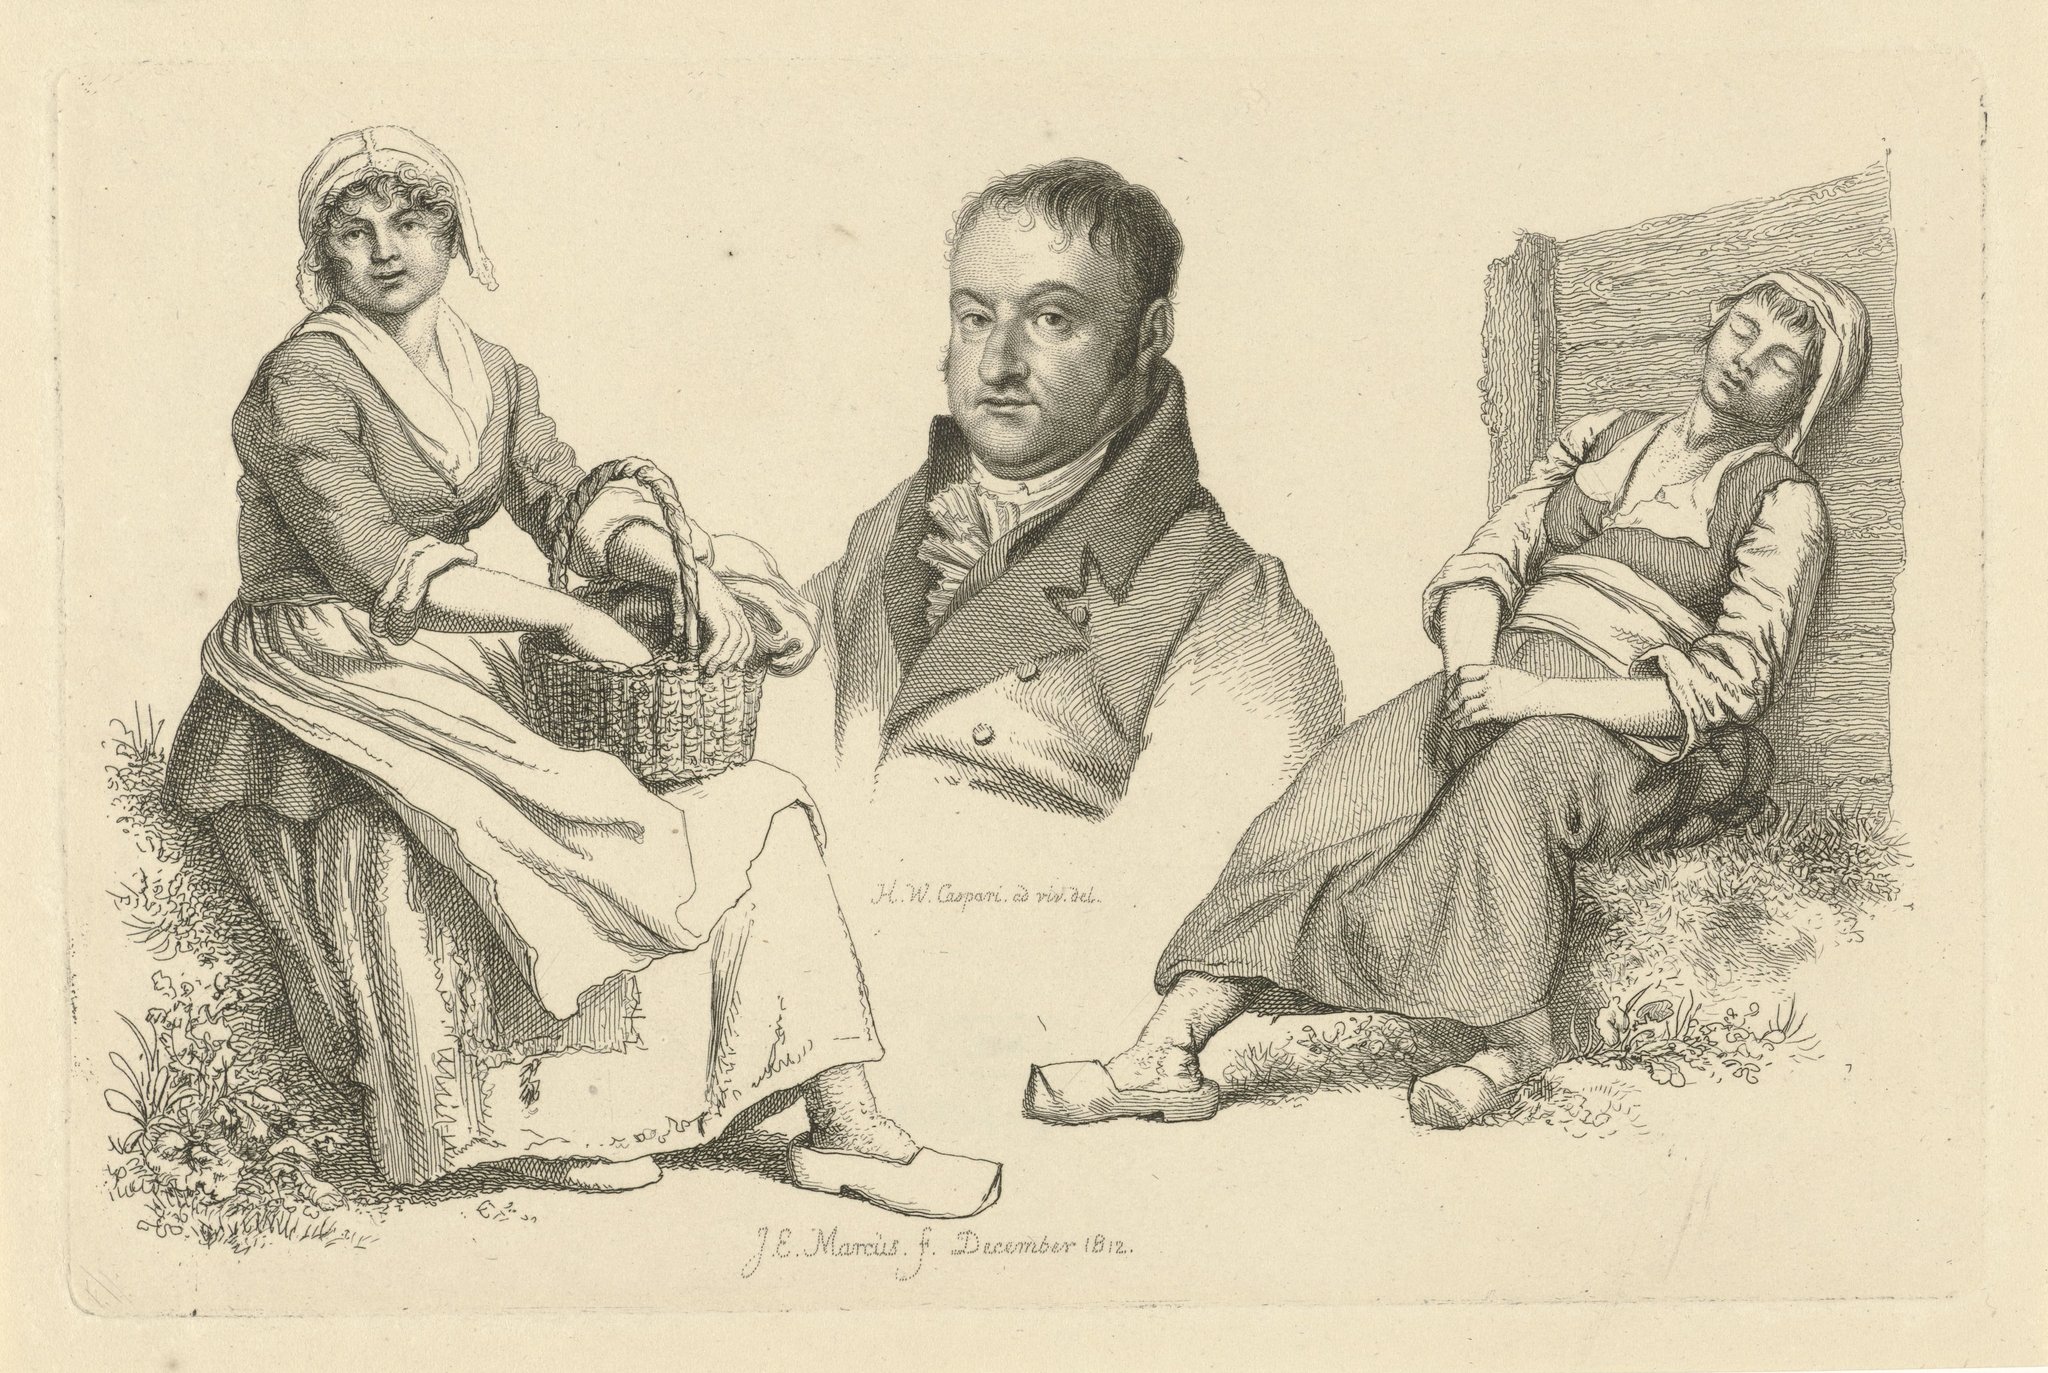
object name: print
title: Portret van Daniel Vrijdag tussen twee boerinnen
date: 1812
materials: paper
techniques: etching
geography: amsterdam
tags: amsterdam, print maker, draughtsman, daniël vrijdag, sitting figure - aa - female human figure, sleeping; unconsciousness - bb - out of doors, wooden shoes, clogs, farmers - aa - female farmer, farmer's wife, container made of plant material other than wood: basket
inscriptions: collector's mark: Lugt 2228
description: Serie voor het eerst uitgegeven door Jacob Ernst Marcus onder de titel Studiebeelden en Fragmenten. Amsterdam: ca.1816. Later heruitgegeven als: Studie-prentwerk/ Etudes gravées.